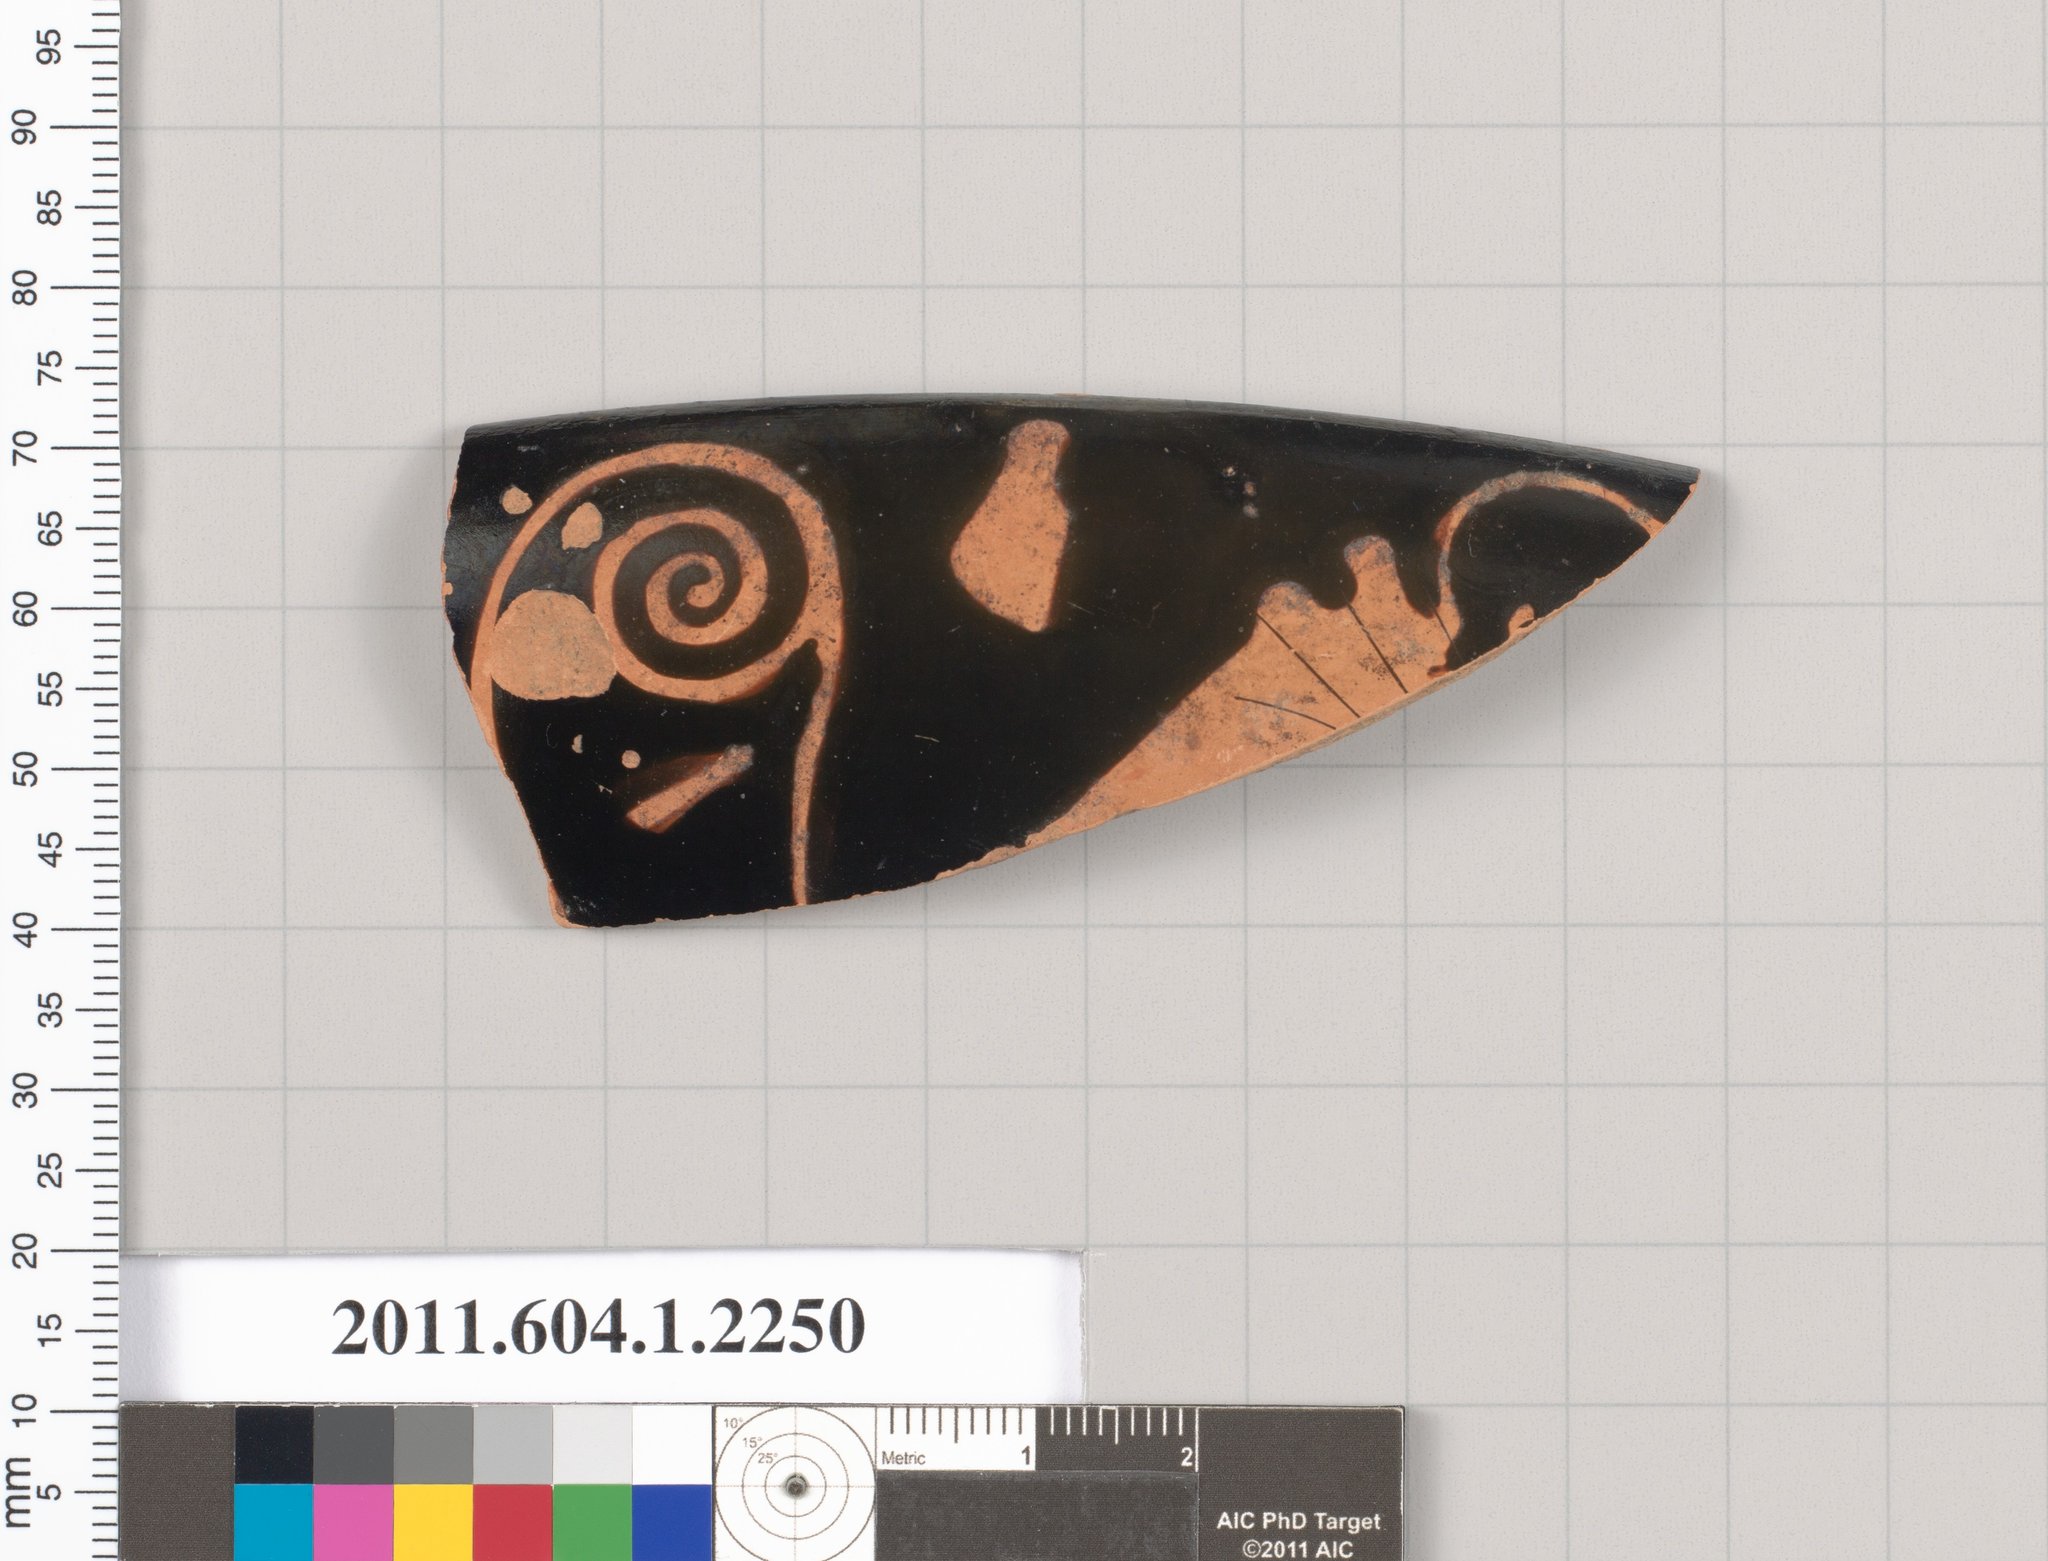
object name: kylix fragment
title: Terracotta rim fragment of a kylix (drinking cup)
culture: greek, attic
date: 475-451 BCE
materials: terracotta